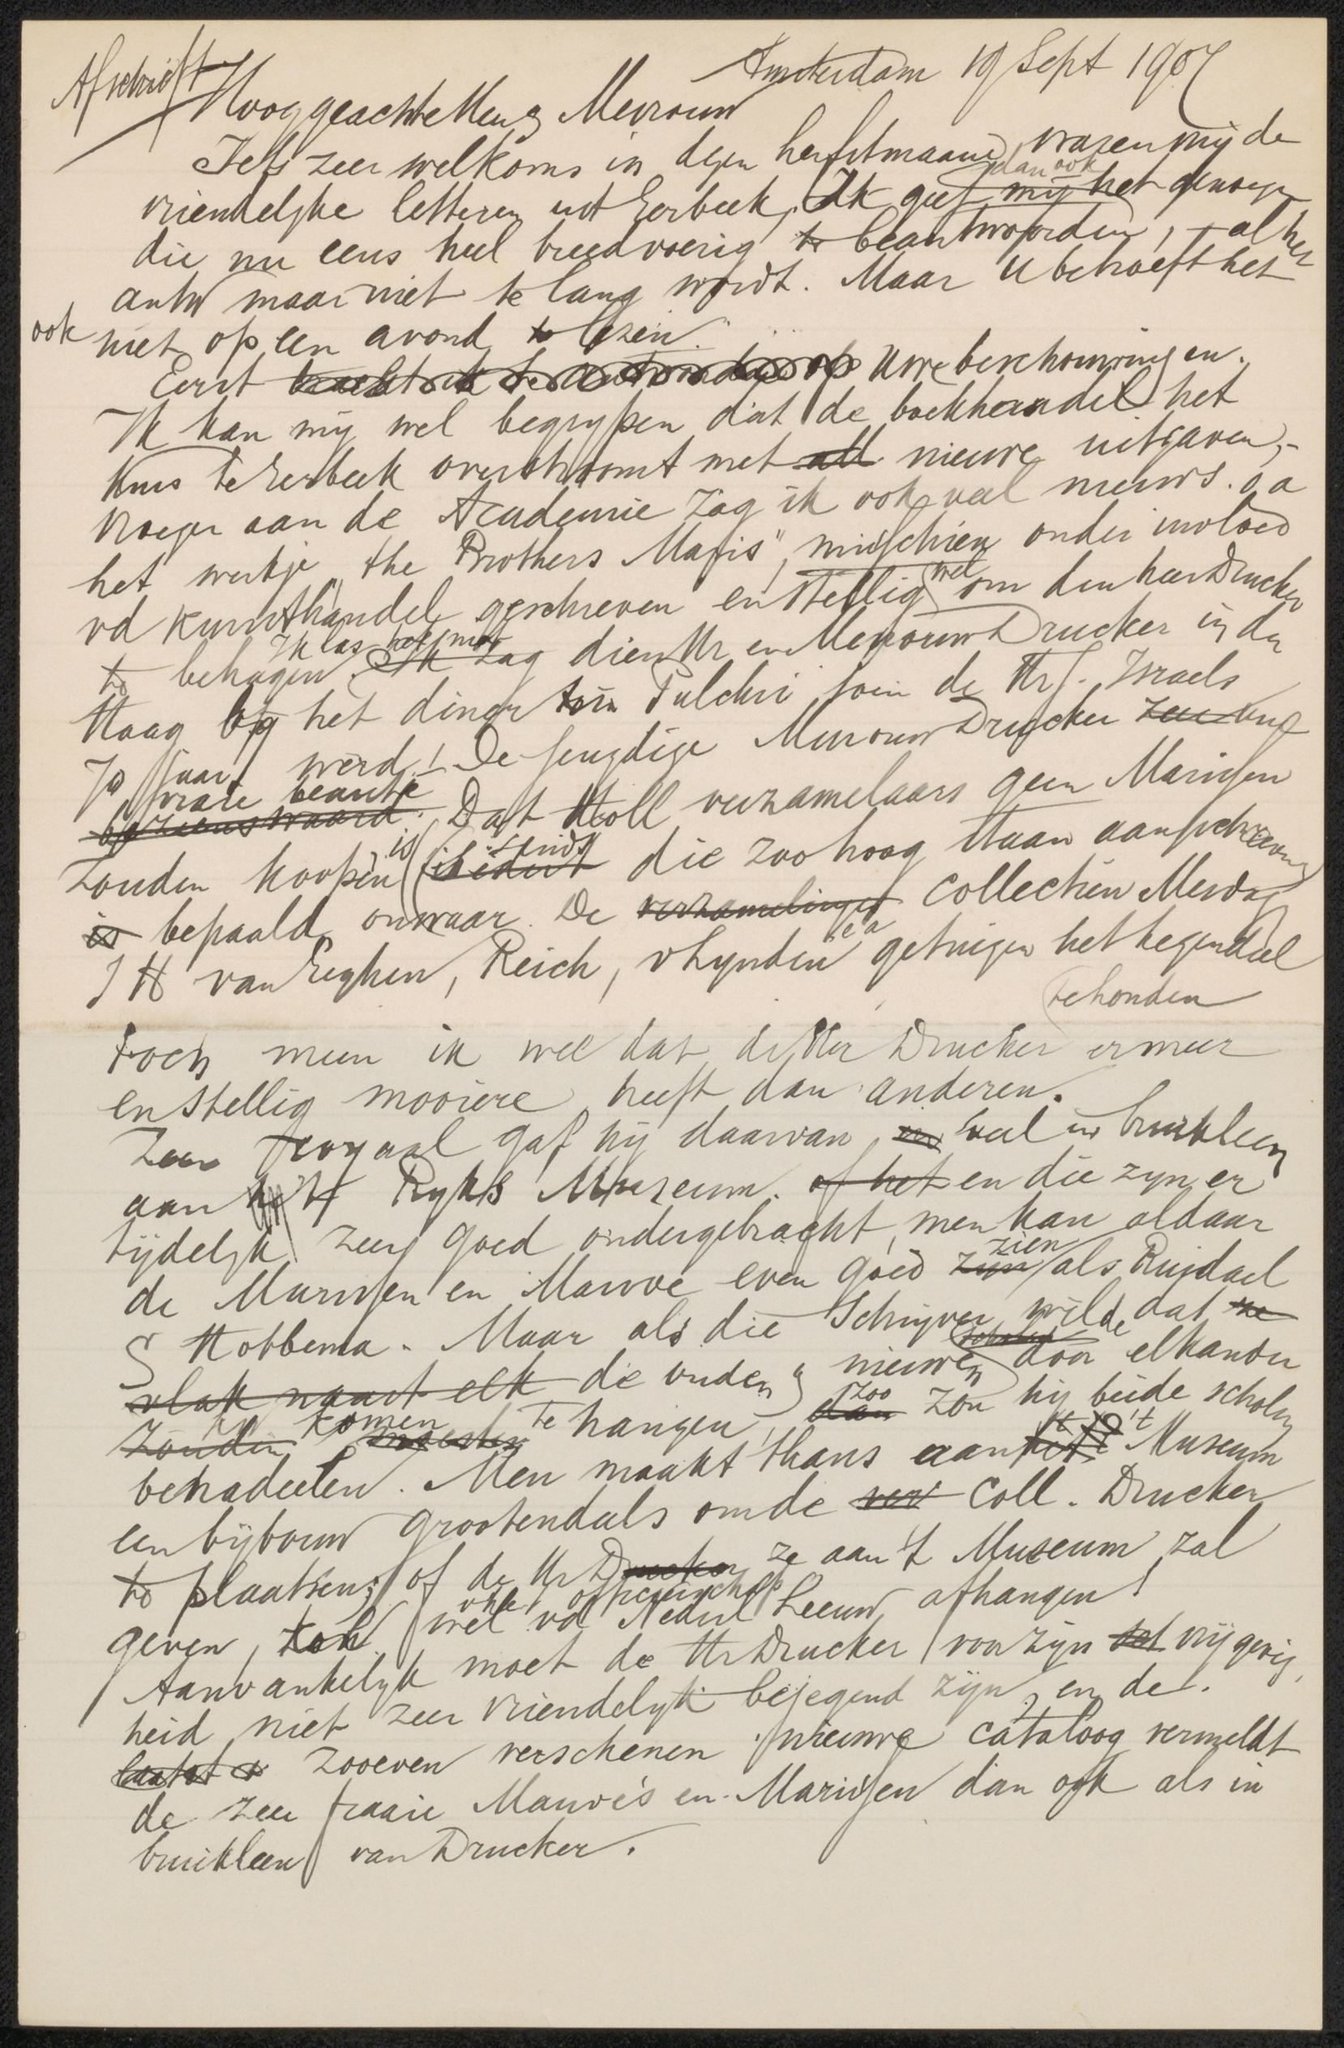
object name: letter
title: Brief aan Max Wilhelm Carl Weber en Anne Antoinette Weber-Van Bosse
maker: august allebé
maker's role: draughtsman, print maker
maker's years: 1838-1927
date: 1907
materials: ink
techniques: pen, writing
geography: amsterdam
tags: jozef israëls, anne antoinette weber-van bosse, the hague, london, painter, print maker, draughtsman, matthijs maris, willem maris, arnhem, anton mauve, jacob maris, maria lydia drucker-fraser, rijksmuseum amsterdam, art collecting, printed matter